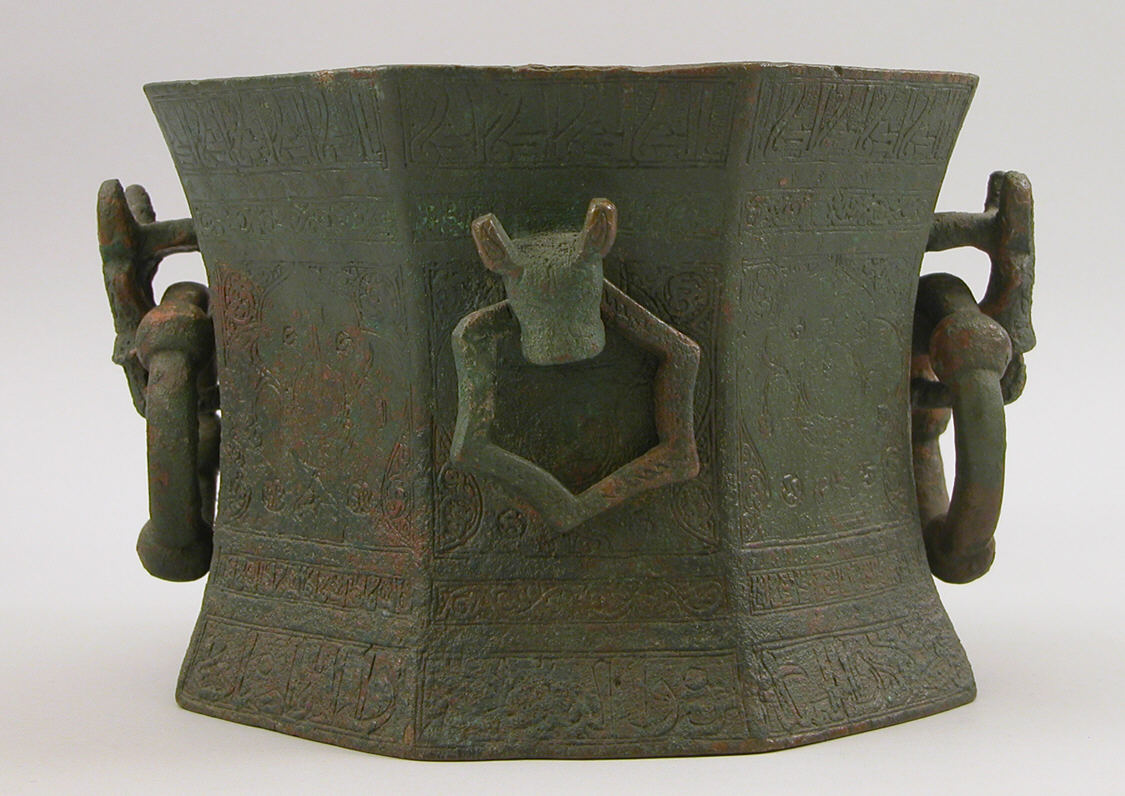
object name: mortar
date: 1101-1300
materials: bronze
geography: central asia